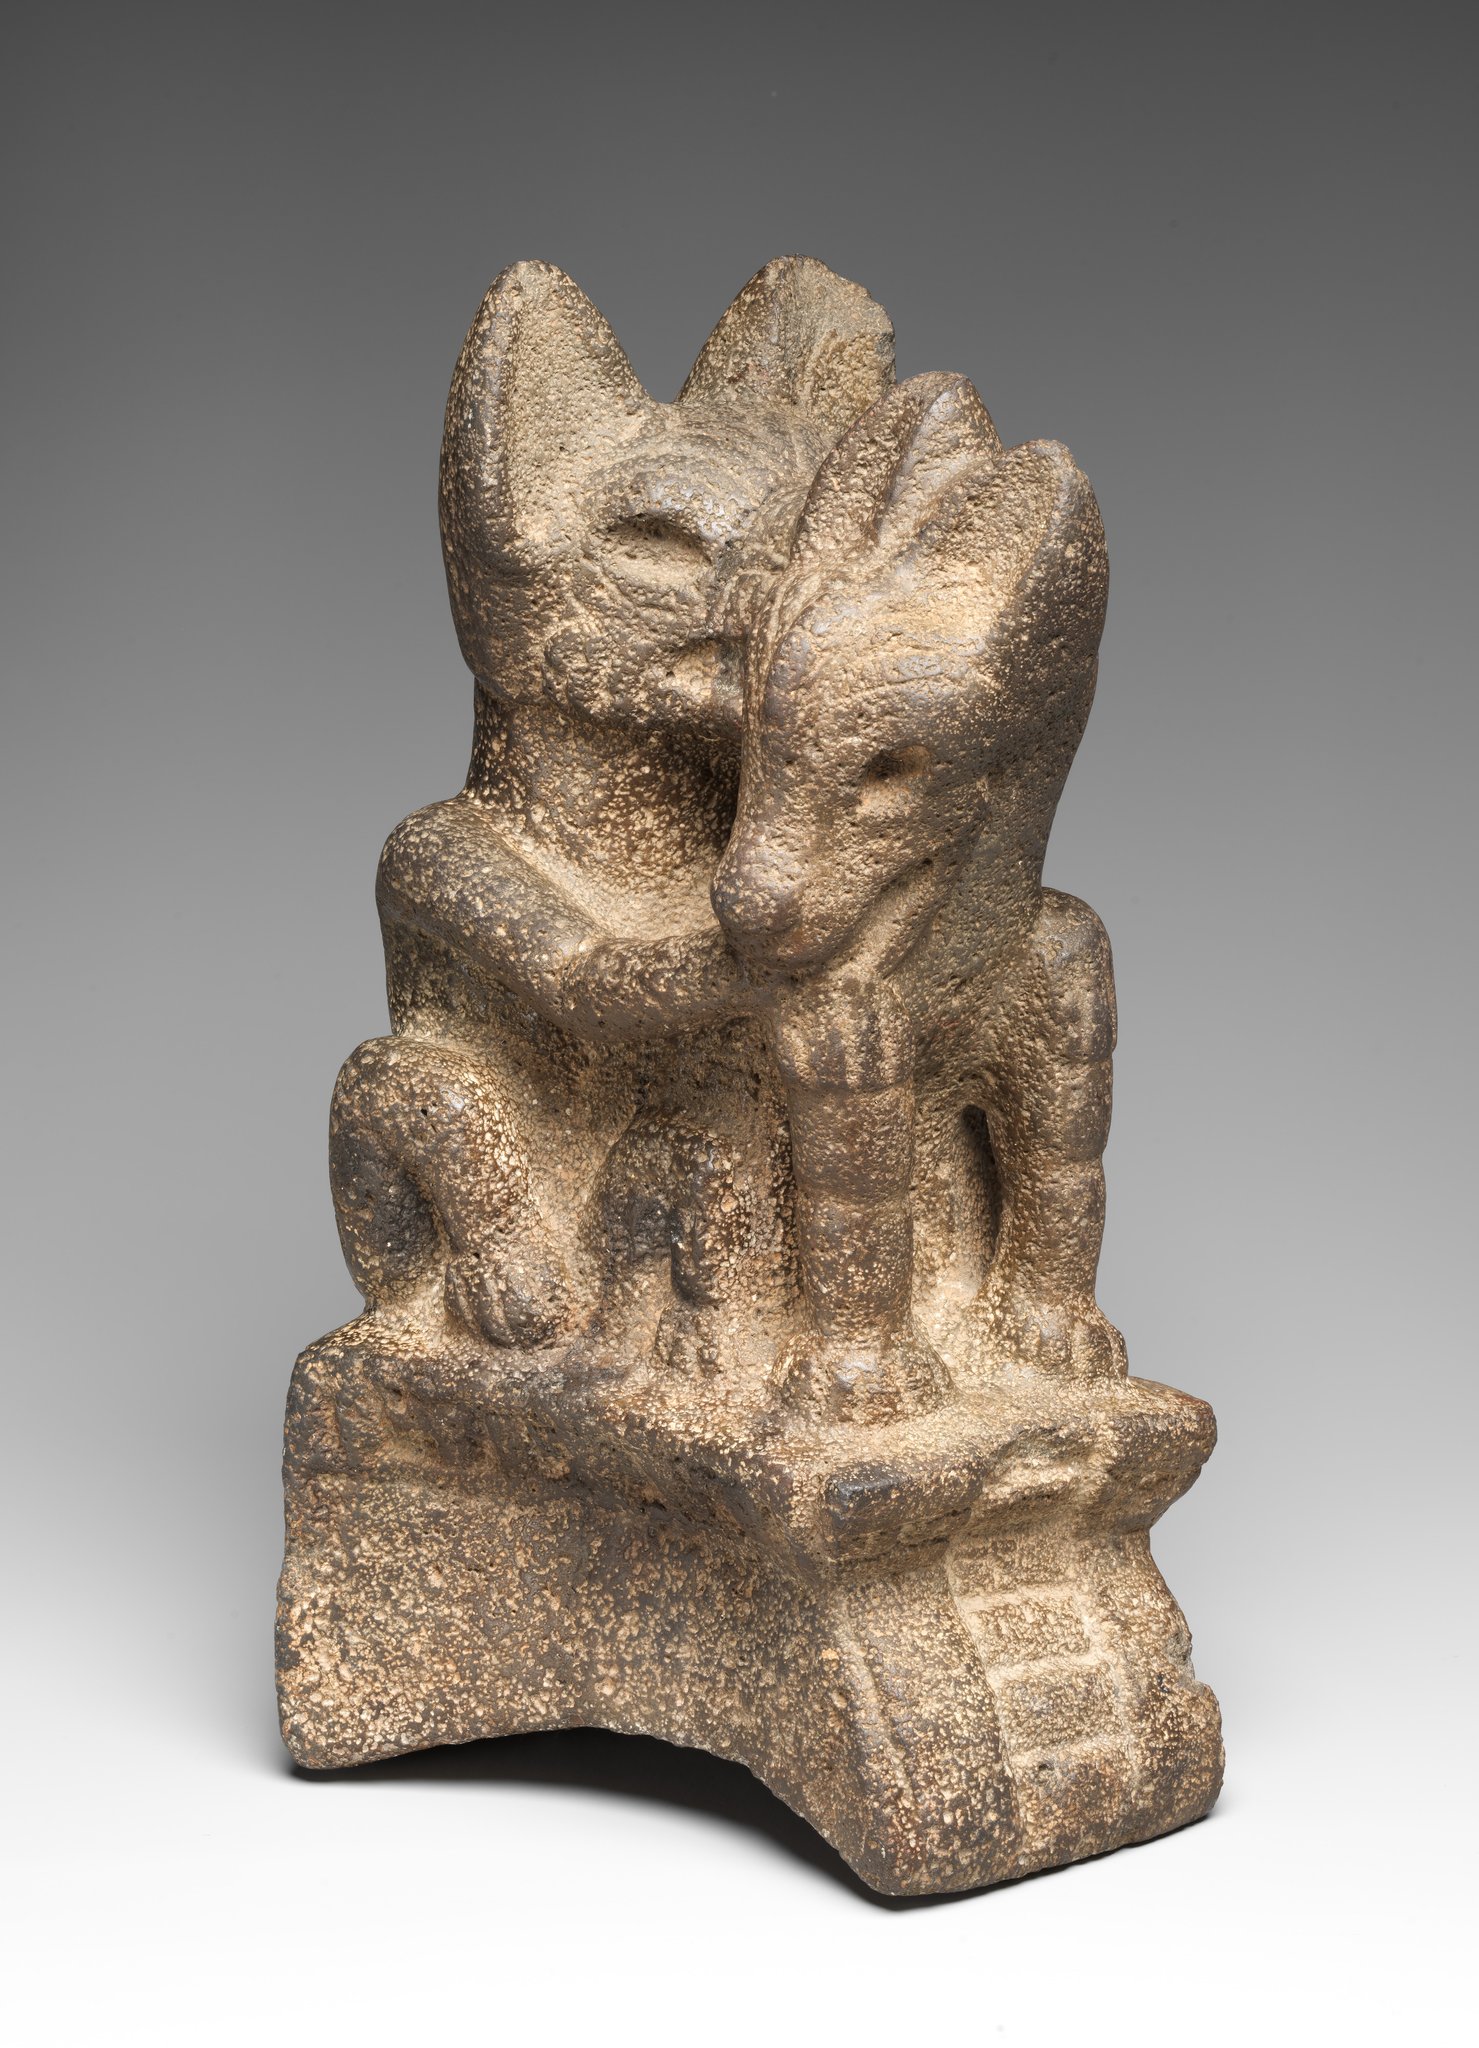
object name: palma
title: Palma with canines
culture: classic veracruz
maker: classic veracruz artist(s)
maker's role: artist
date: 800-1100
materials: pigment, stone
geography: mexico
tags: animals